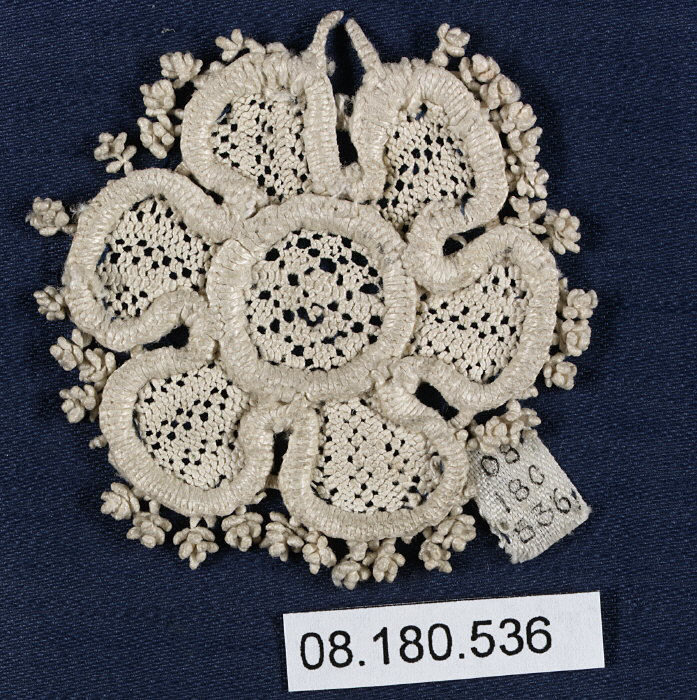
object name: ornament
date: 1601-1700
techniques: lace